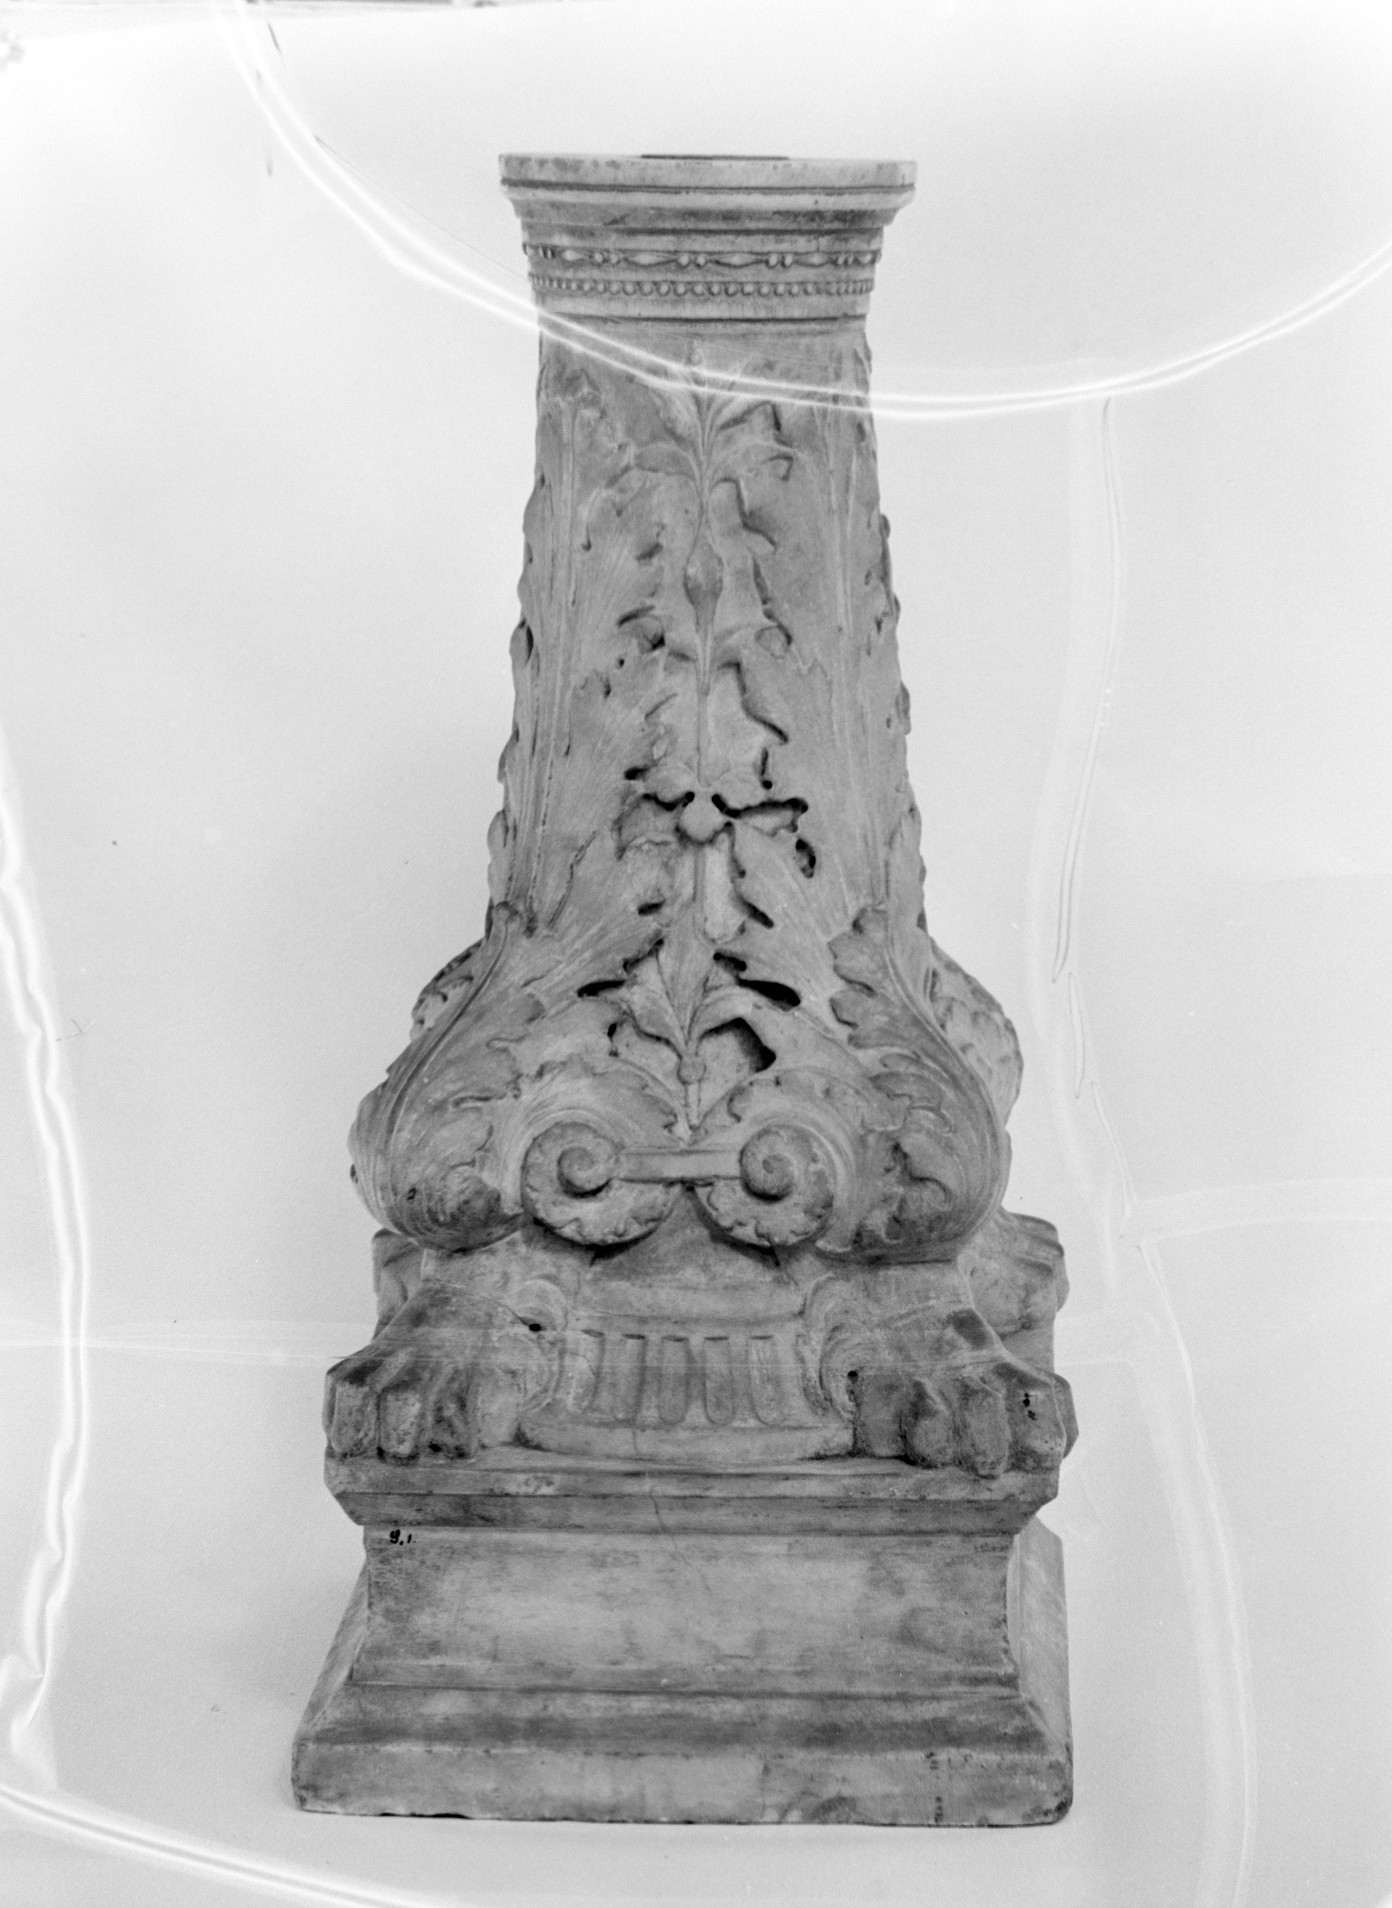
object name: pedestal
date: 1501-1600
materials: marble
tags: acanthus